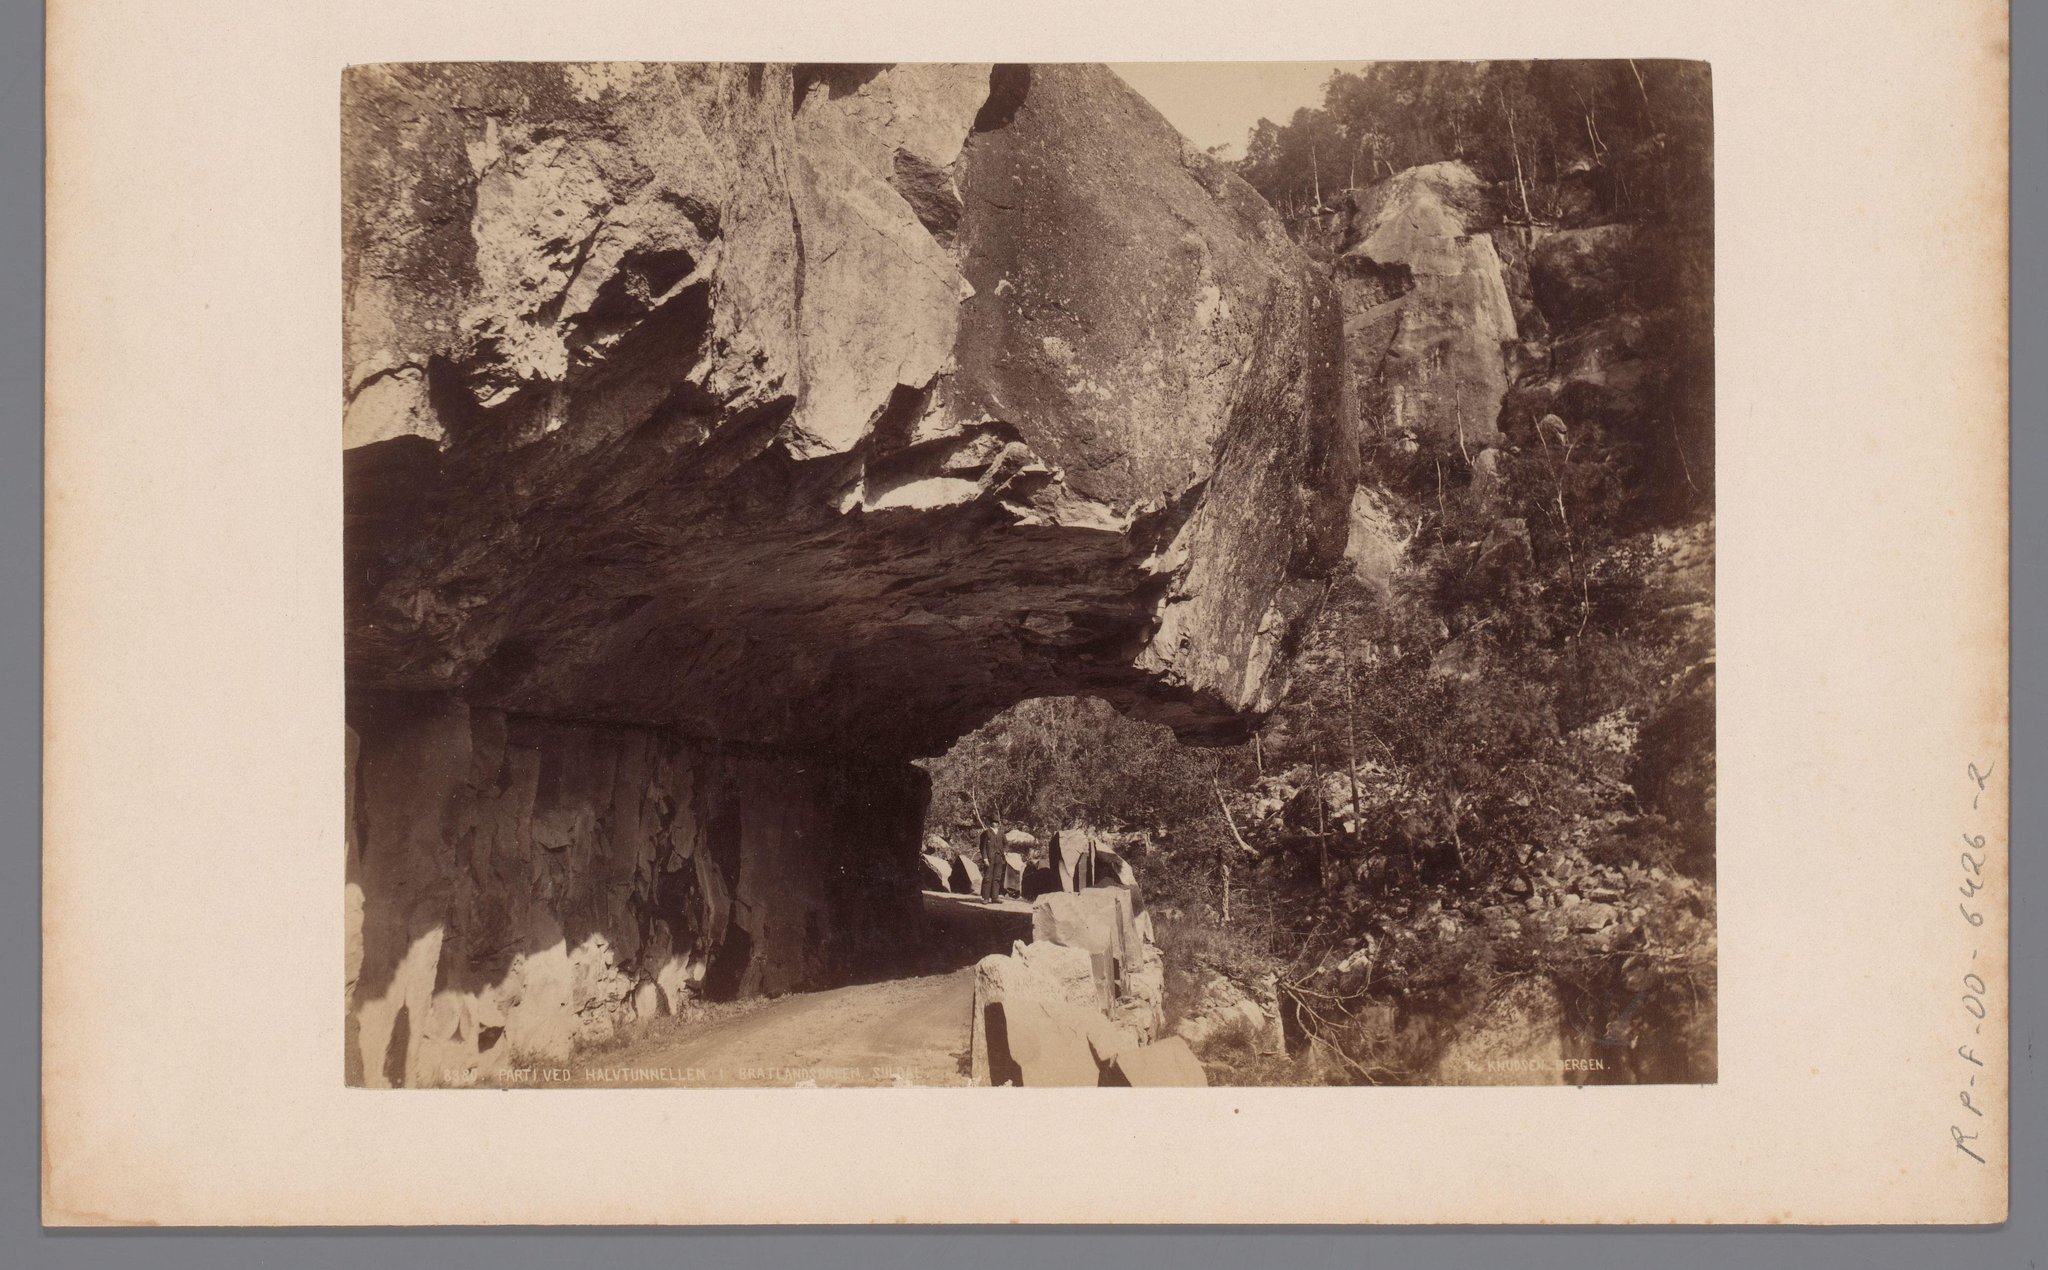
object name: photograph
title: Parti ved halvtunnellen I Bratlandsdalen, Suldal, Noorwegen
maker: knud knudsen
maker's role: fotograaf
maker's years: 1832-1915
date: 1880-1900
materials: cardboard, photographic support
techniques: albumen print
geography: bergen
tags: norway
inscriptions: inscription: ‘8380. Parti ved halvtunnellen I Bratlandsdalen, Suldal’, inscription: ‘K. Knudsen, Bergen.’